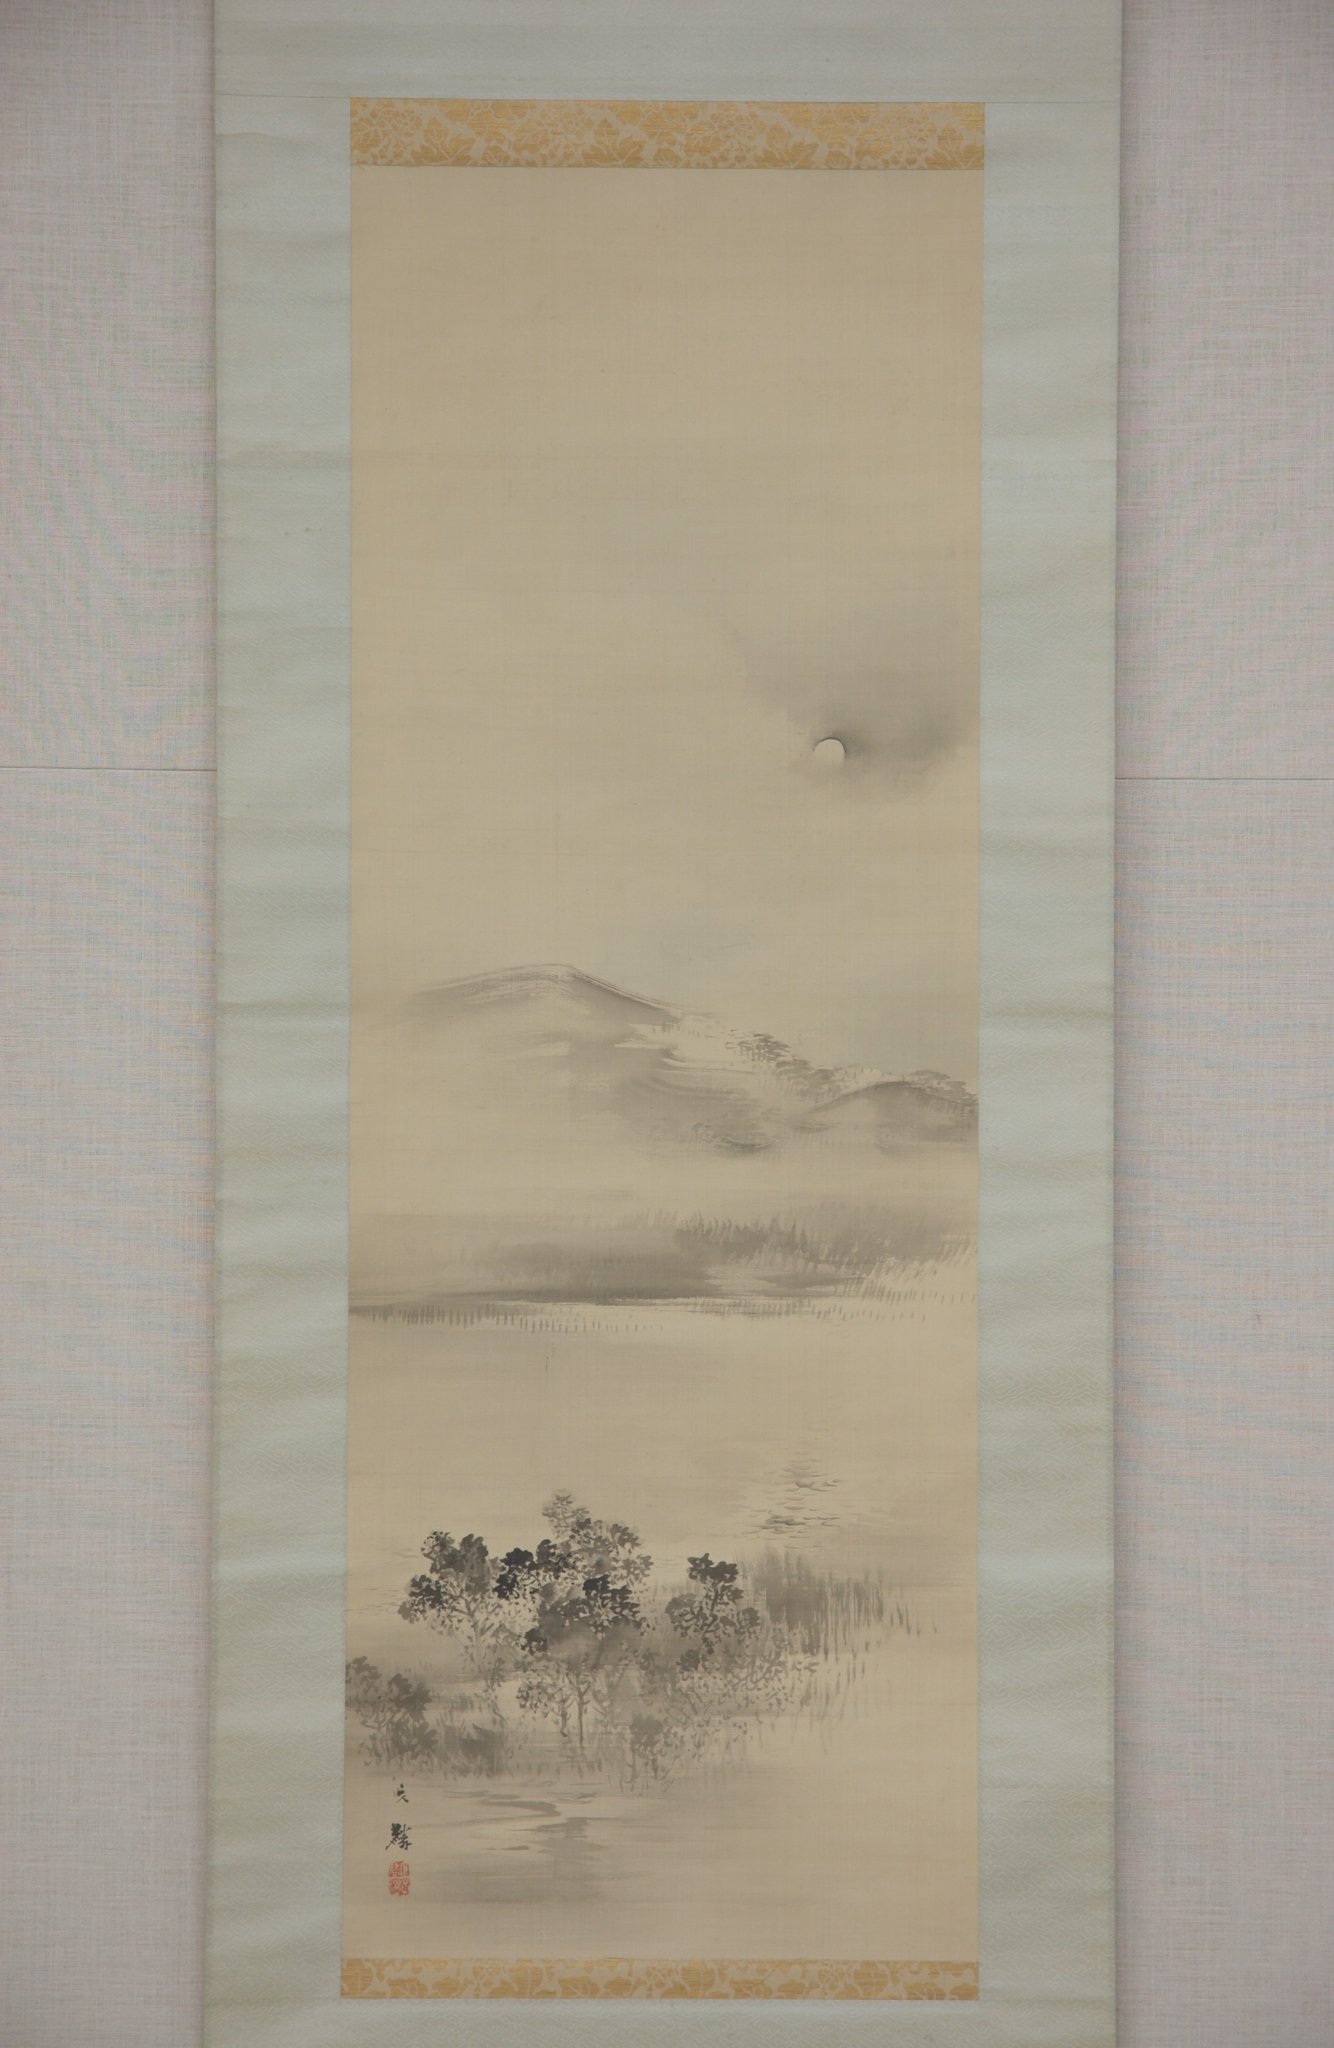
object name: hanging scroll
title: Landscape with the Moon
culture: japanese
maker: shiokawa bunrin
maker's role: artist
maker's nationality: japanese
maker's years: 1808-1877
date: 1801-1900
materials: ink, silk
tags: moon,mountains,landscapes